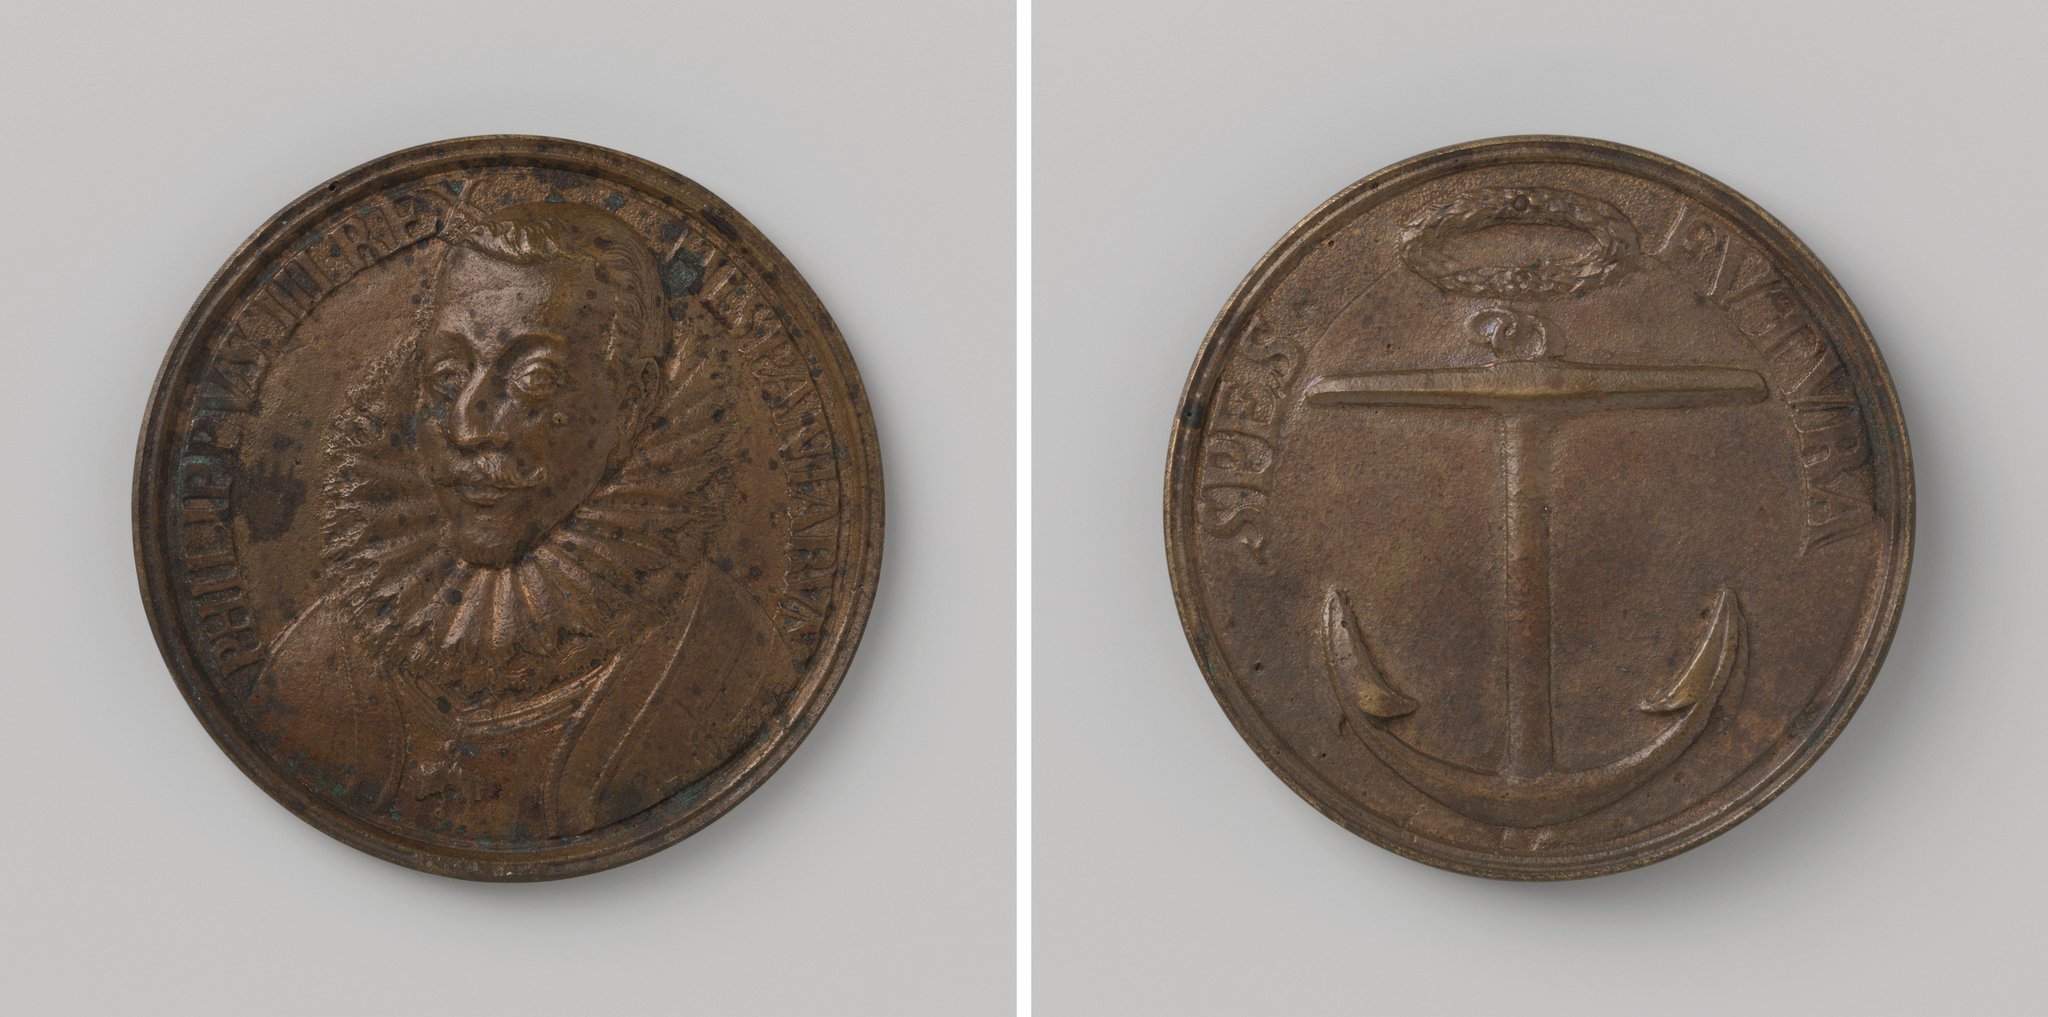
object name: medal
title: Philips III, koning van Spanje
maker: Anonymous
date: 1598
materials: bronze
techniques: striking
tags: filips iii (koning van spanje)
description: Bronzen penning. Voorzijde: borststuk man binnen omschrift. Keerzijde: anker bekroond met lauwerkrans binnen omschrift